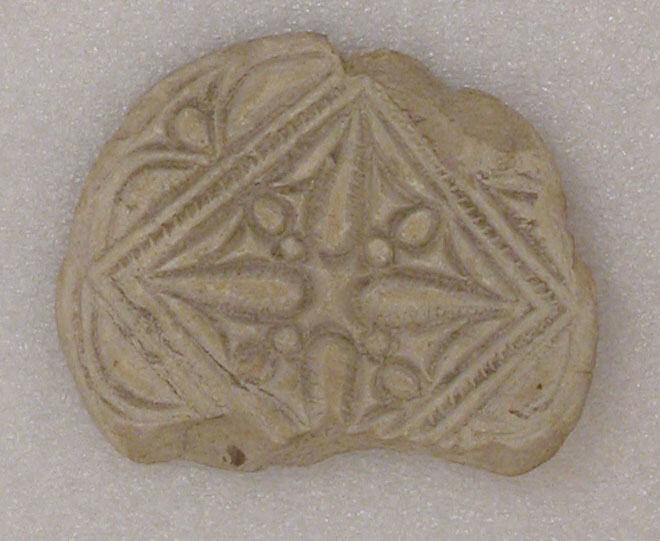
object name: seal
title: Bread Seal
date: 901-1000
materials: earthenware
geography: egypt